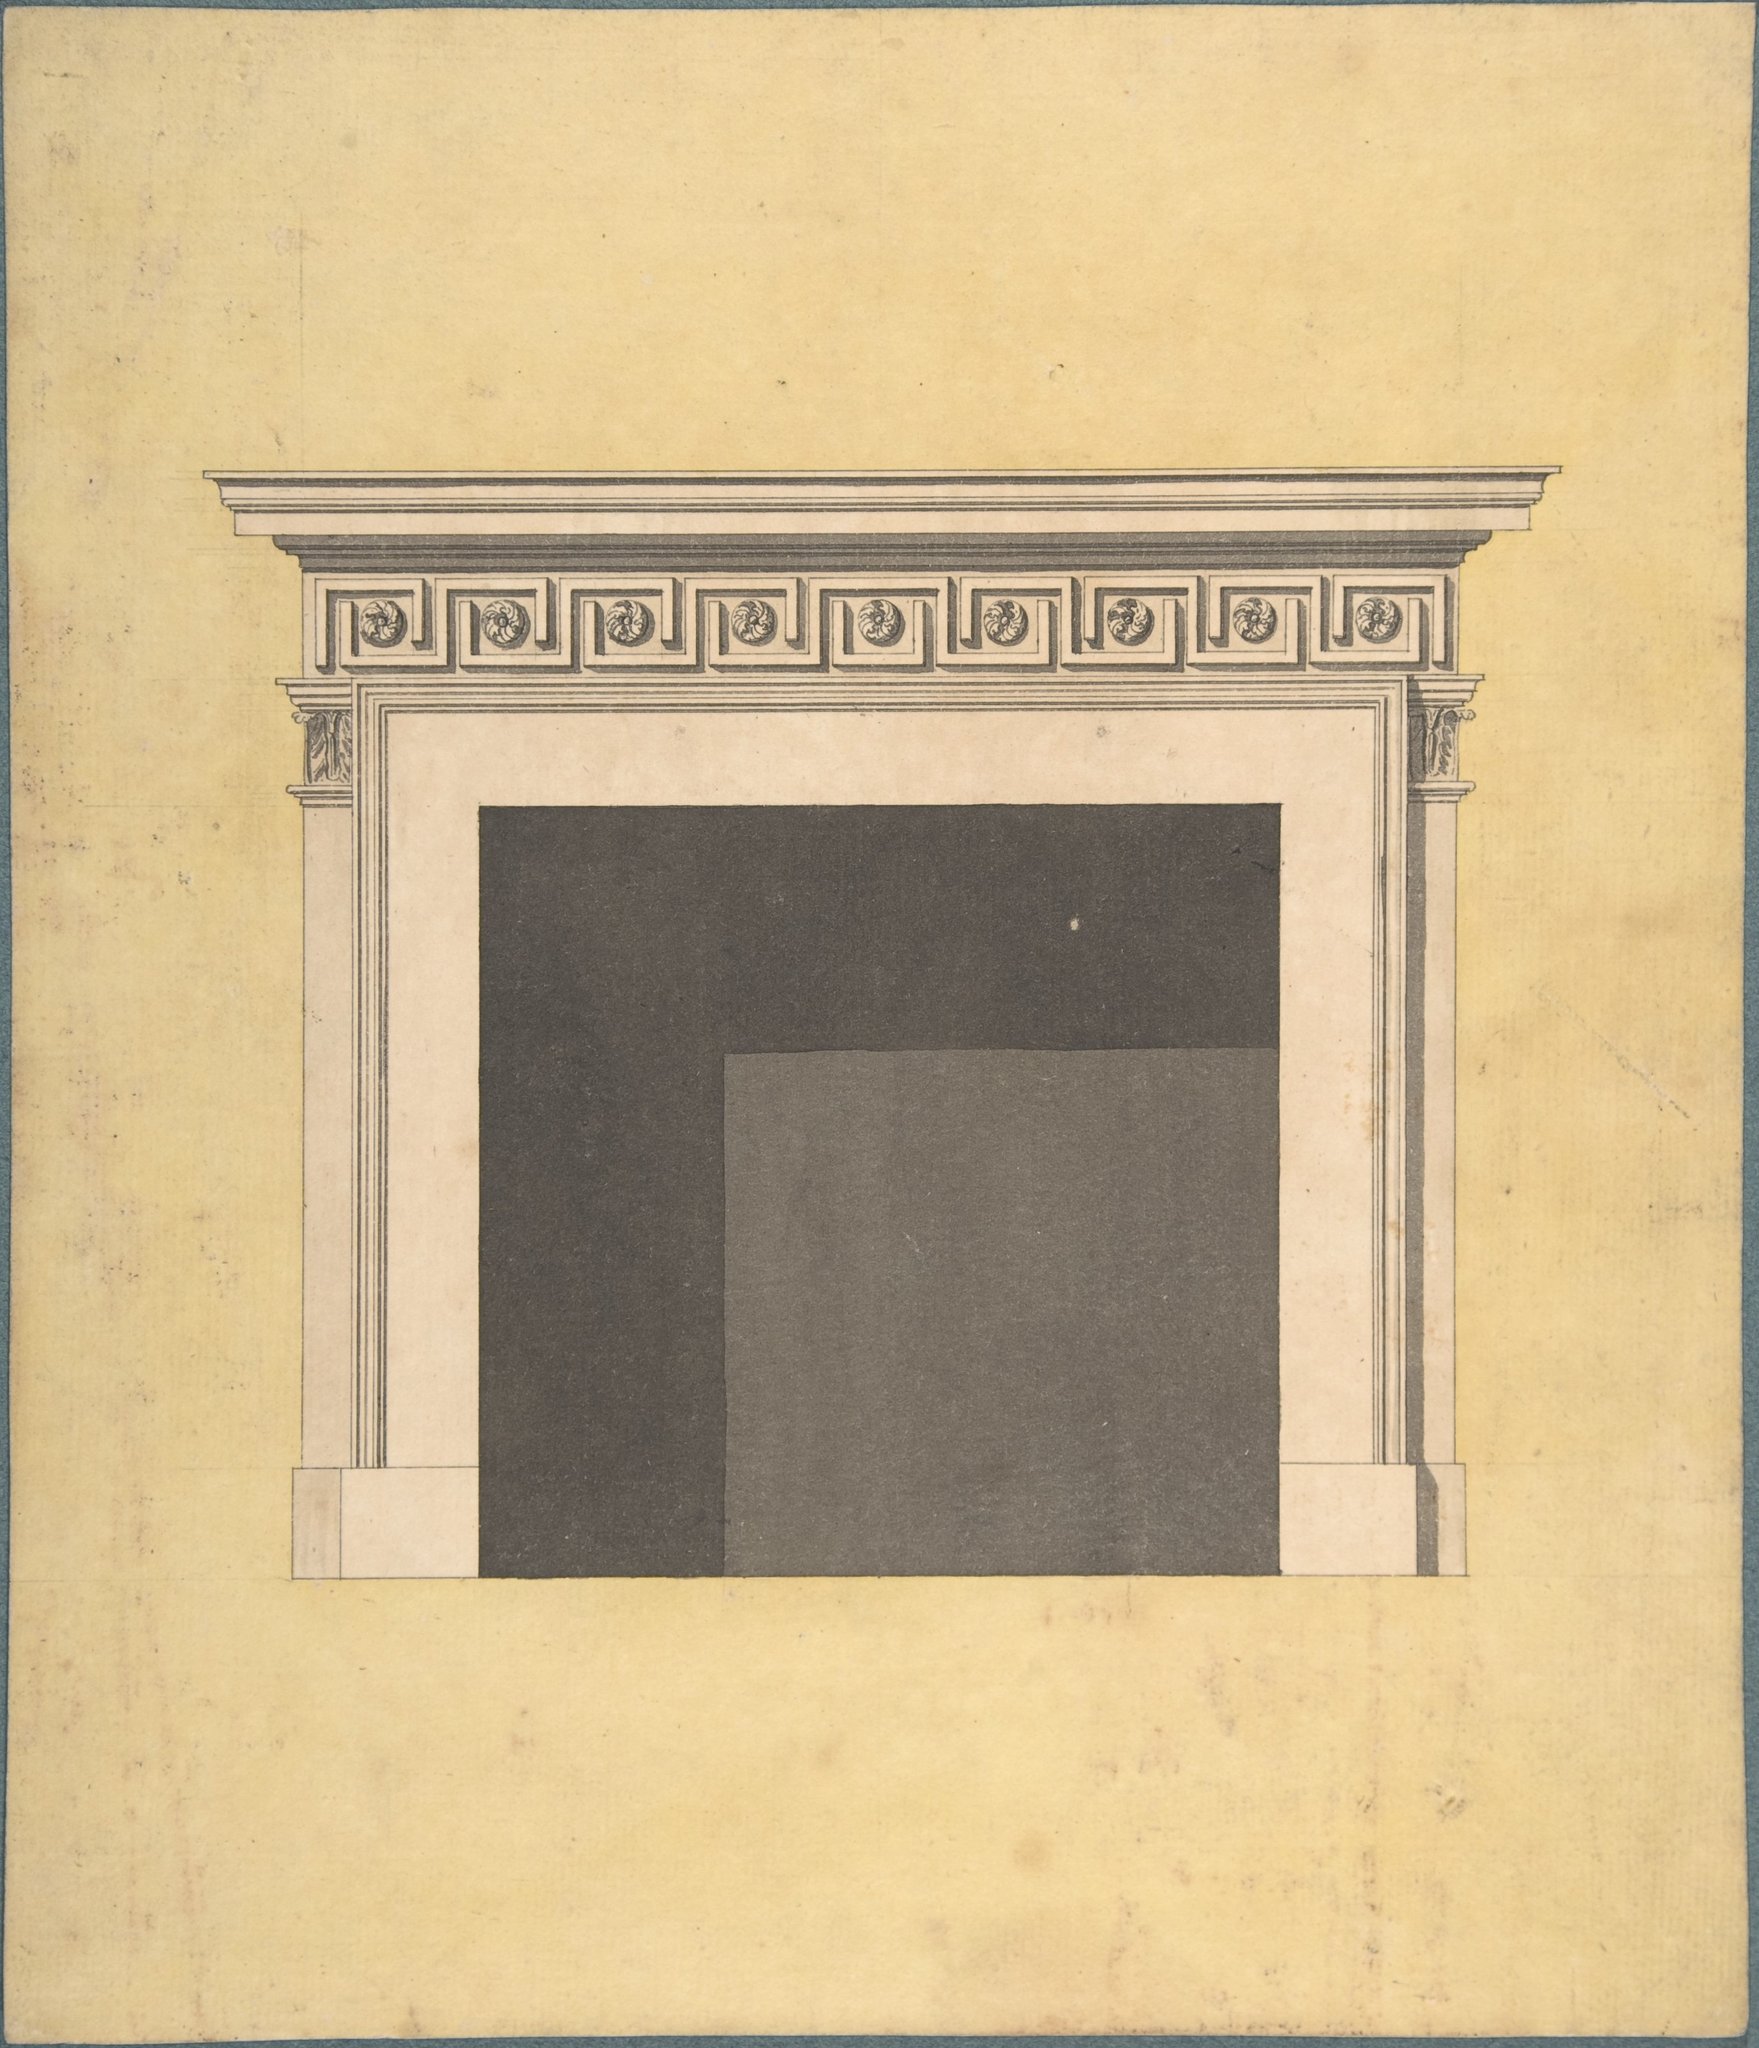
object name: drawing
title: Design for a Chimneypiece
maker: john yenn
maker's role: artist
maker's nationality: british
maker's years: 1750-1821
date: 1767-1833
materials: ink, watercolor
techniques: pen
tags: fireplaces